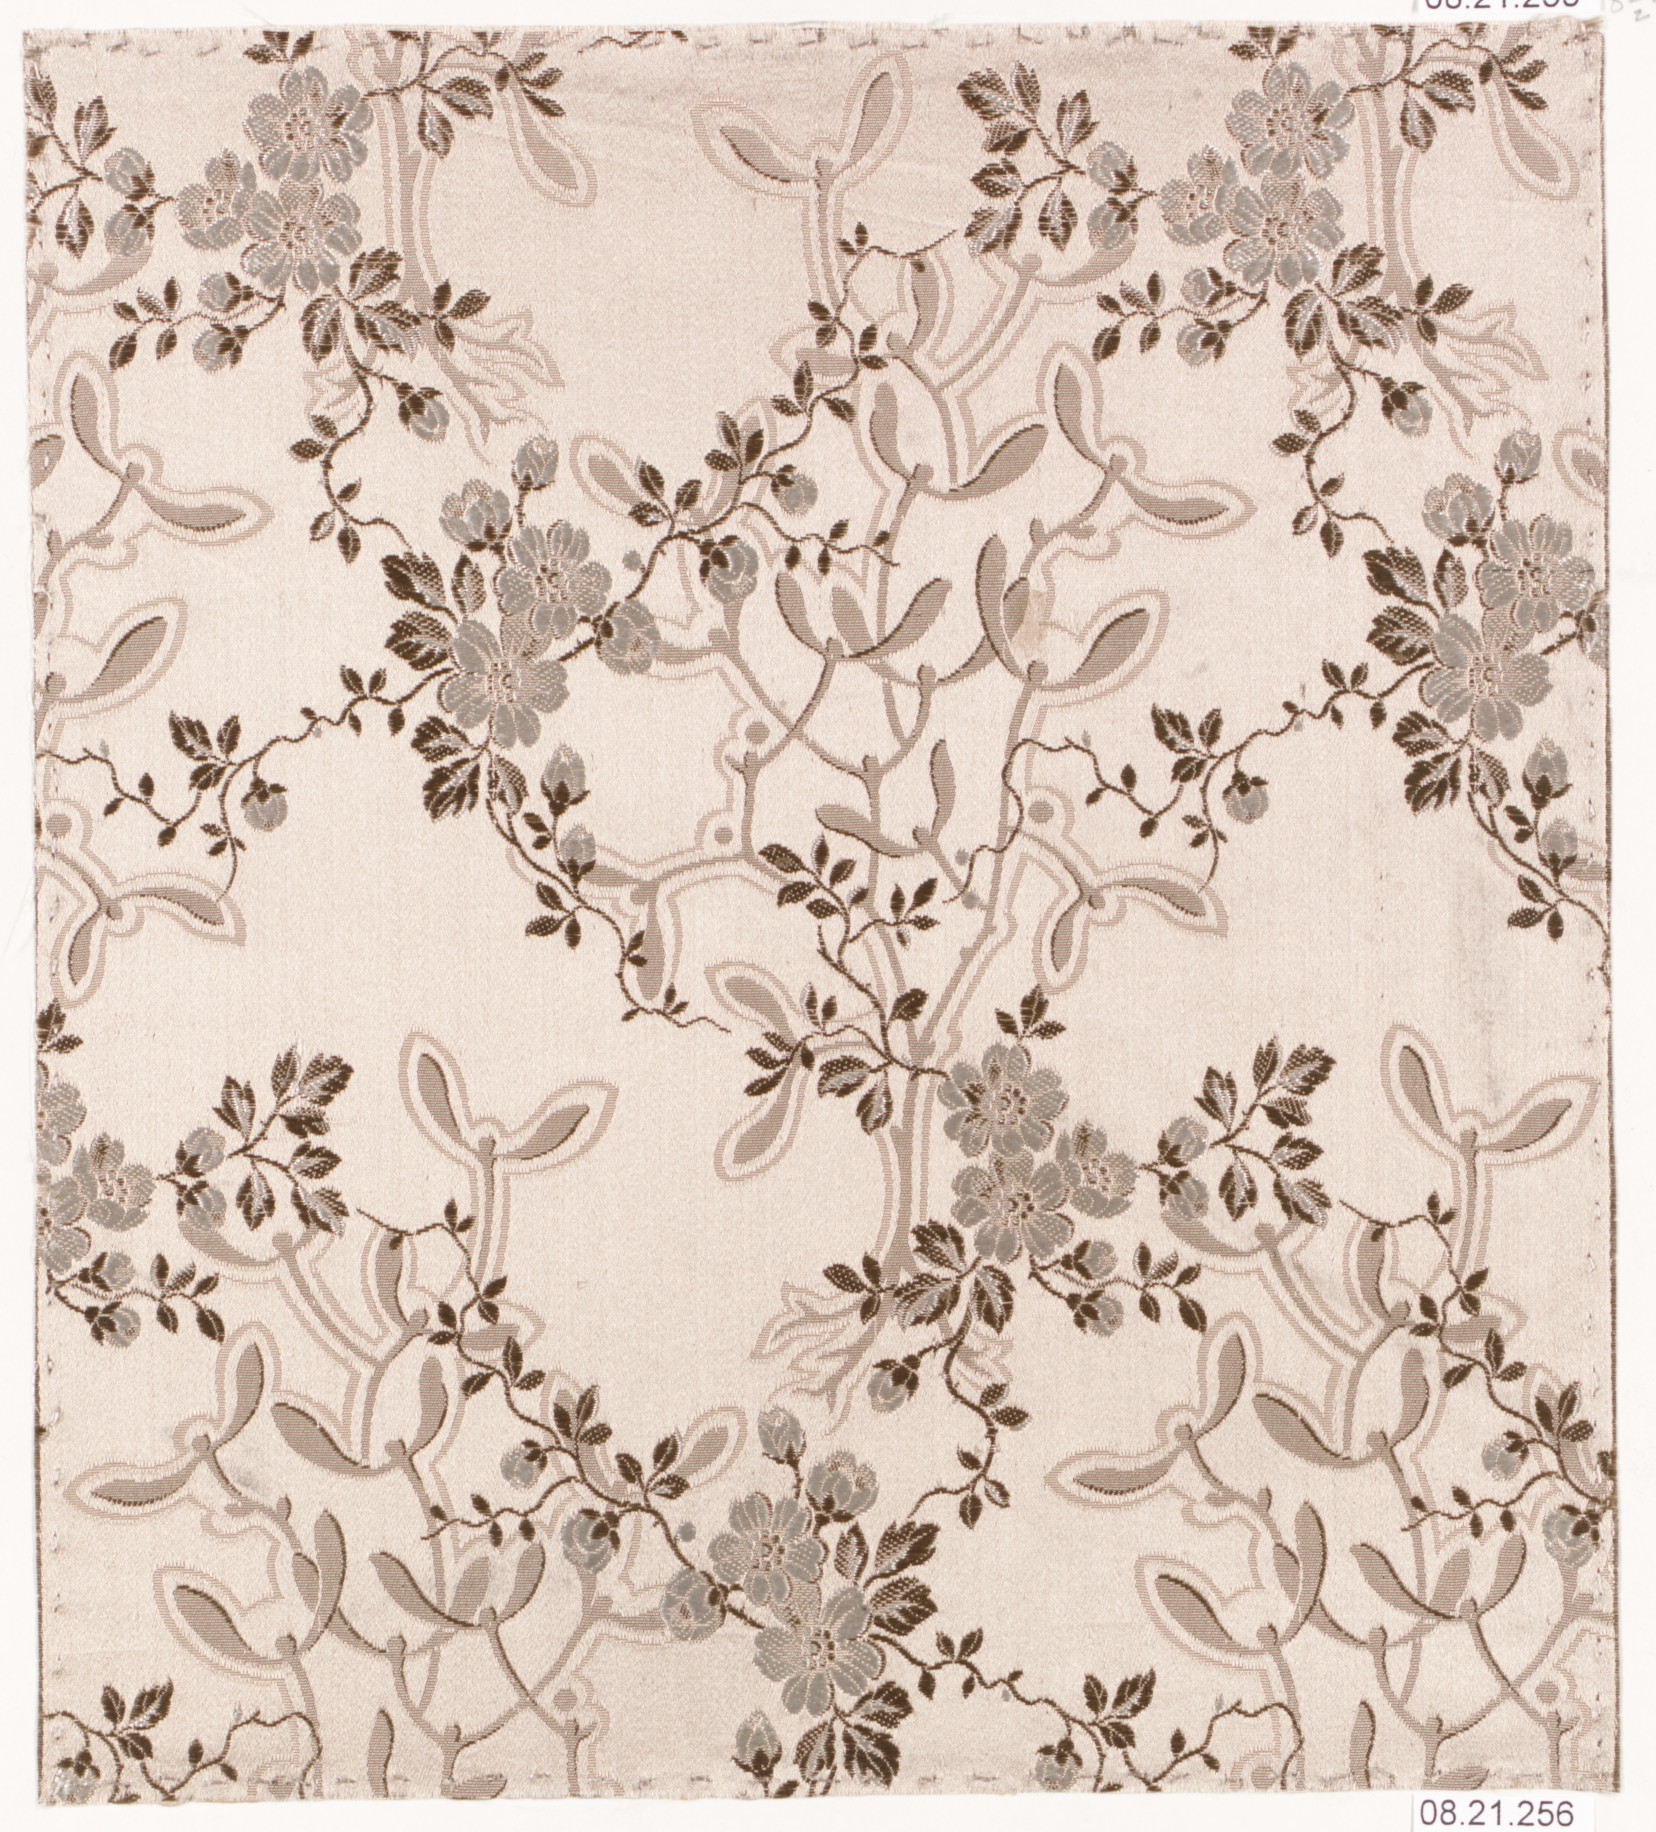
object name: textile sample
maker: Anonymous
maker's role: designer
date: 1900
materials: silk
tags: flowers